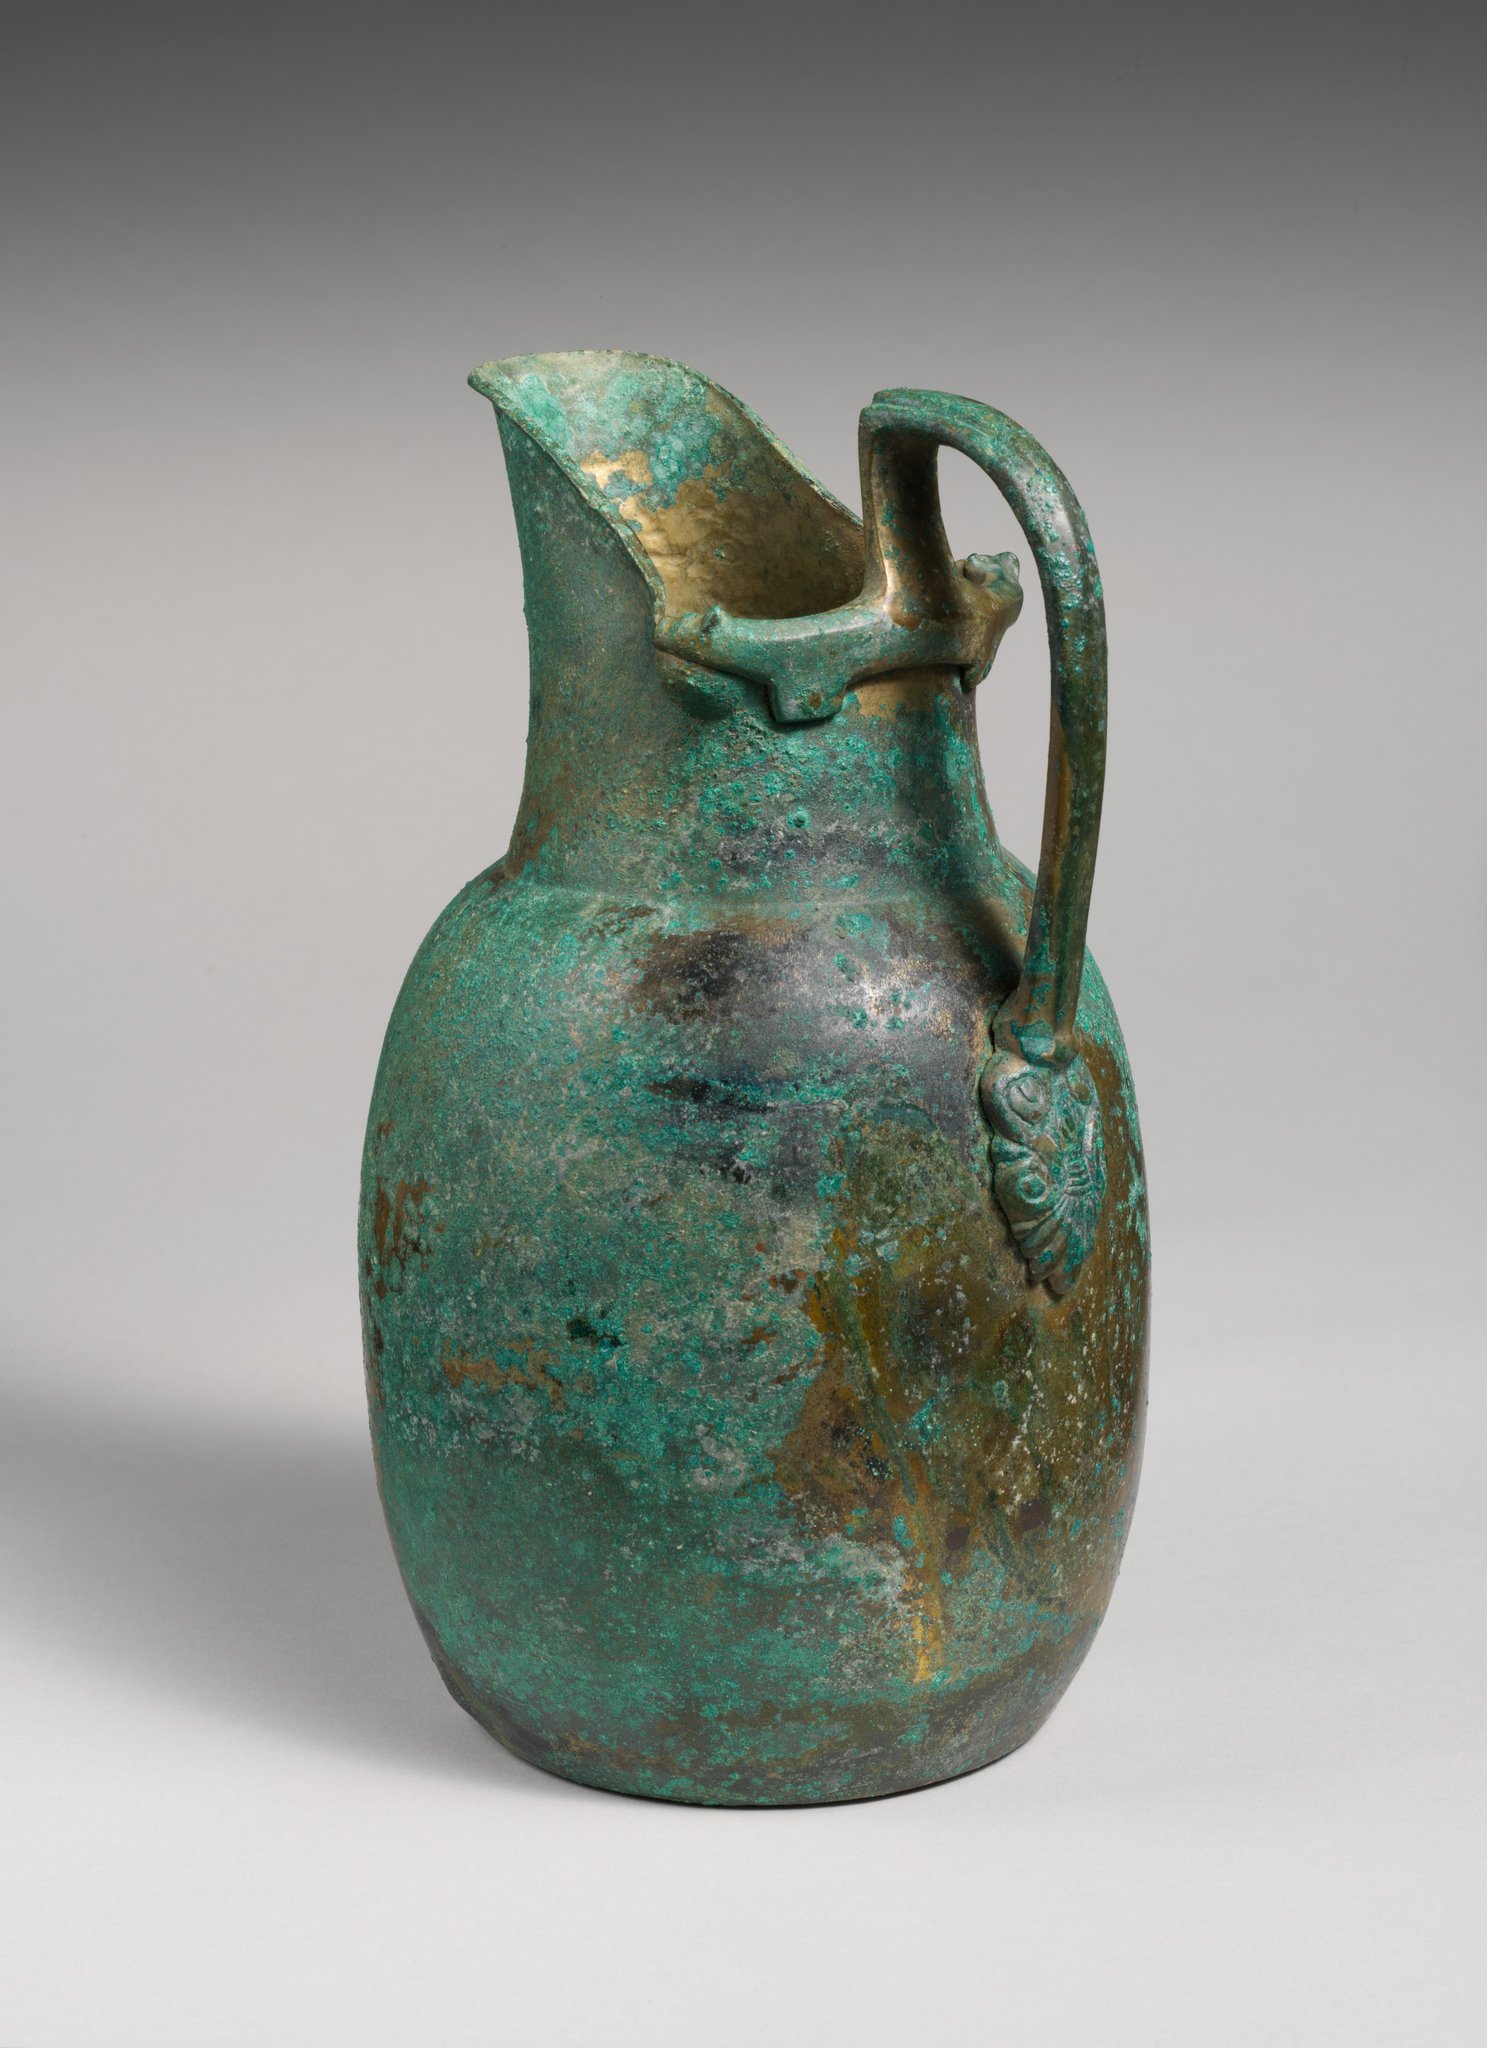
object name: oinochoe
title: Bronze oinochoe (jug)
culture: etruscan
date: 550 BCE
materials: bronze